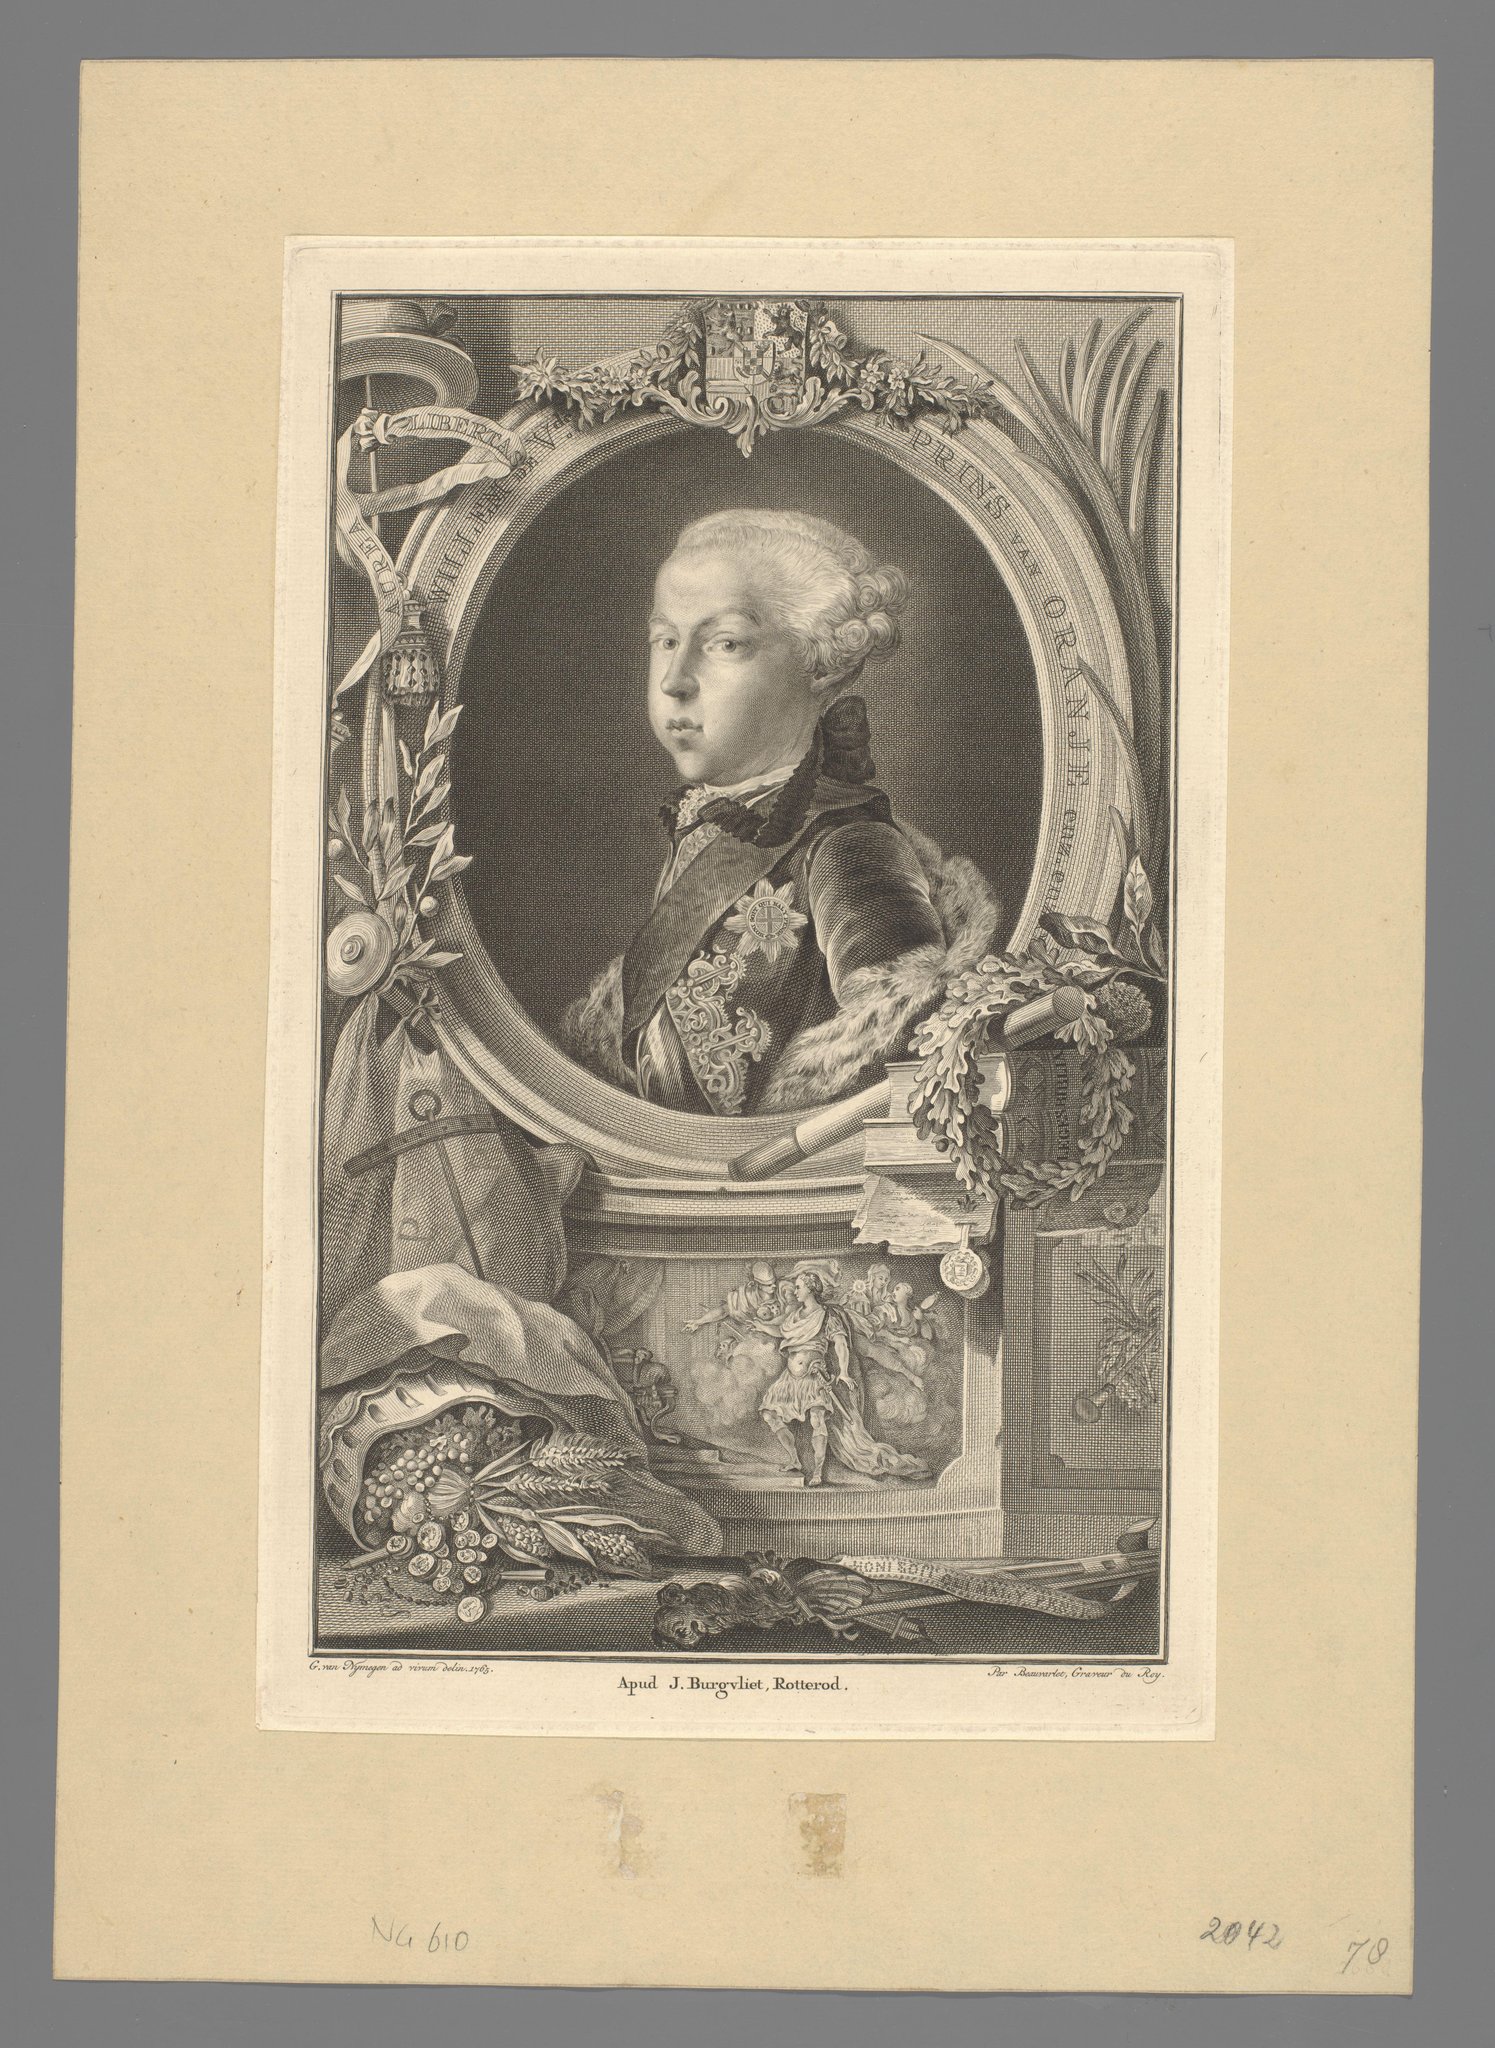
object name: print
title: Portret van Willem V, prins van Oranje-Nassau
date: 1765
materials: paper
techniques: engraving, etching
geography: paris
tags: the hague, william v (prince of orange), knighthood order (garter) - insignia of a knighthood order, e.g.: badge, chain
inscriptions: date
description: Portret van Willem V in een ovaal met randschrift. Midden boven zijn wapen. Rondom liggen een meerdere allegorische objecten, waaronder een commandostaf, een lauwerkrans en een oranjetak. Op het reliëf een allegorische voorstelling.